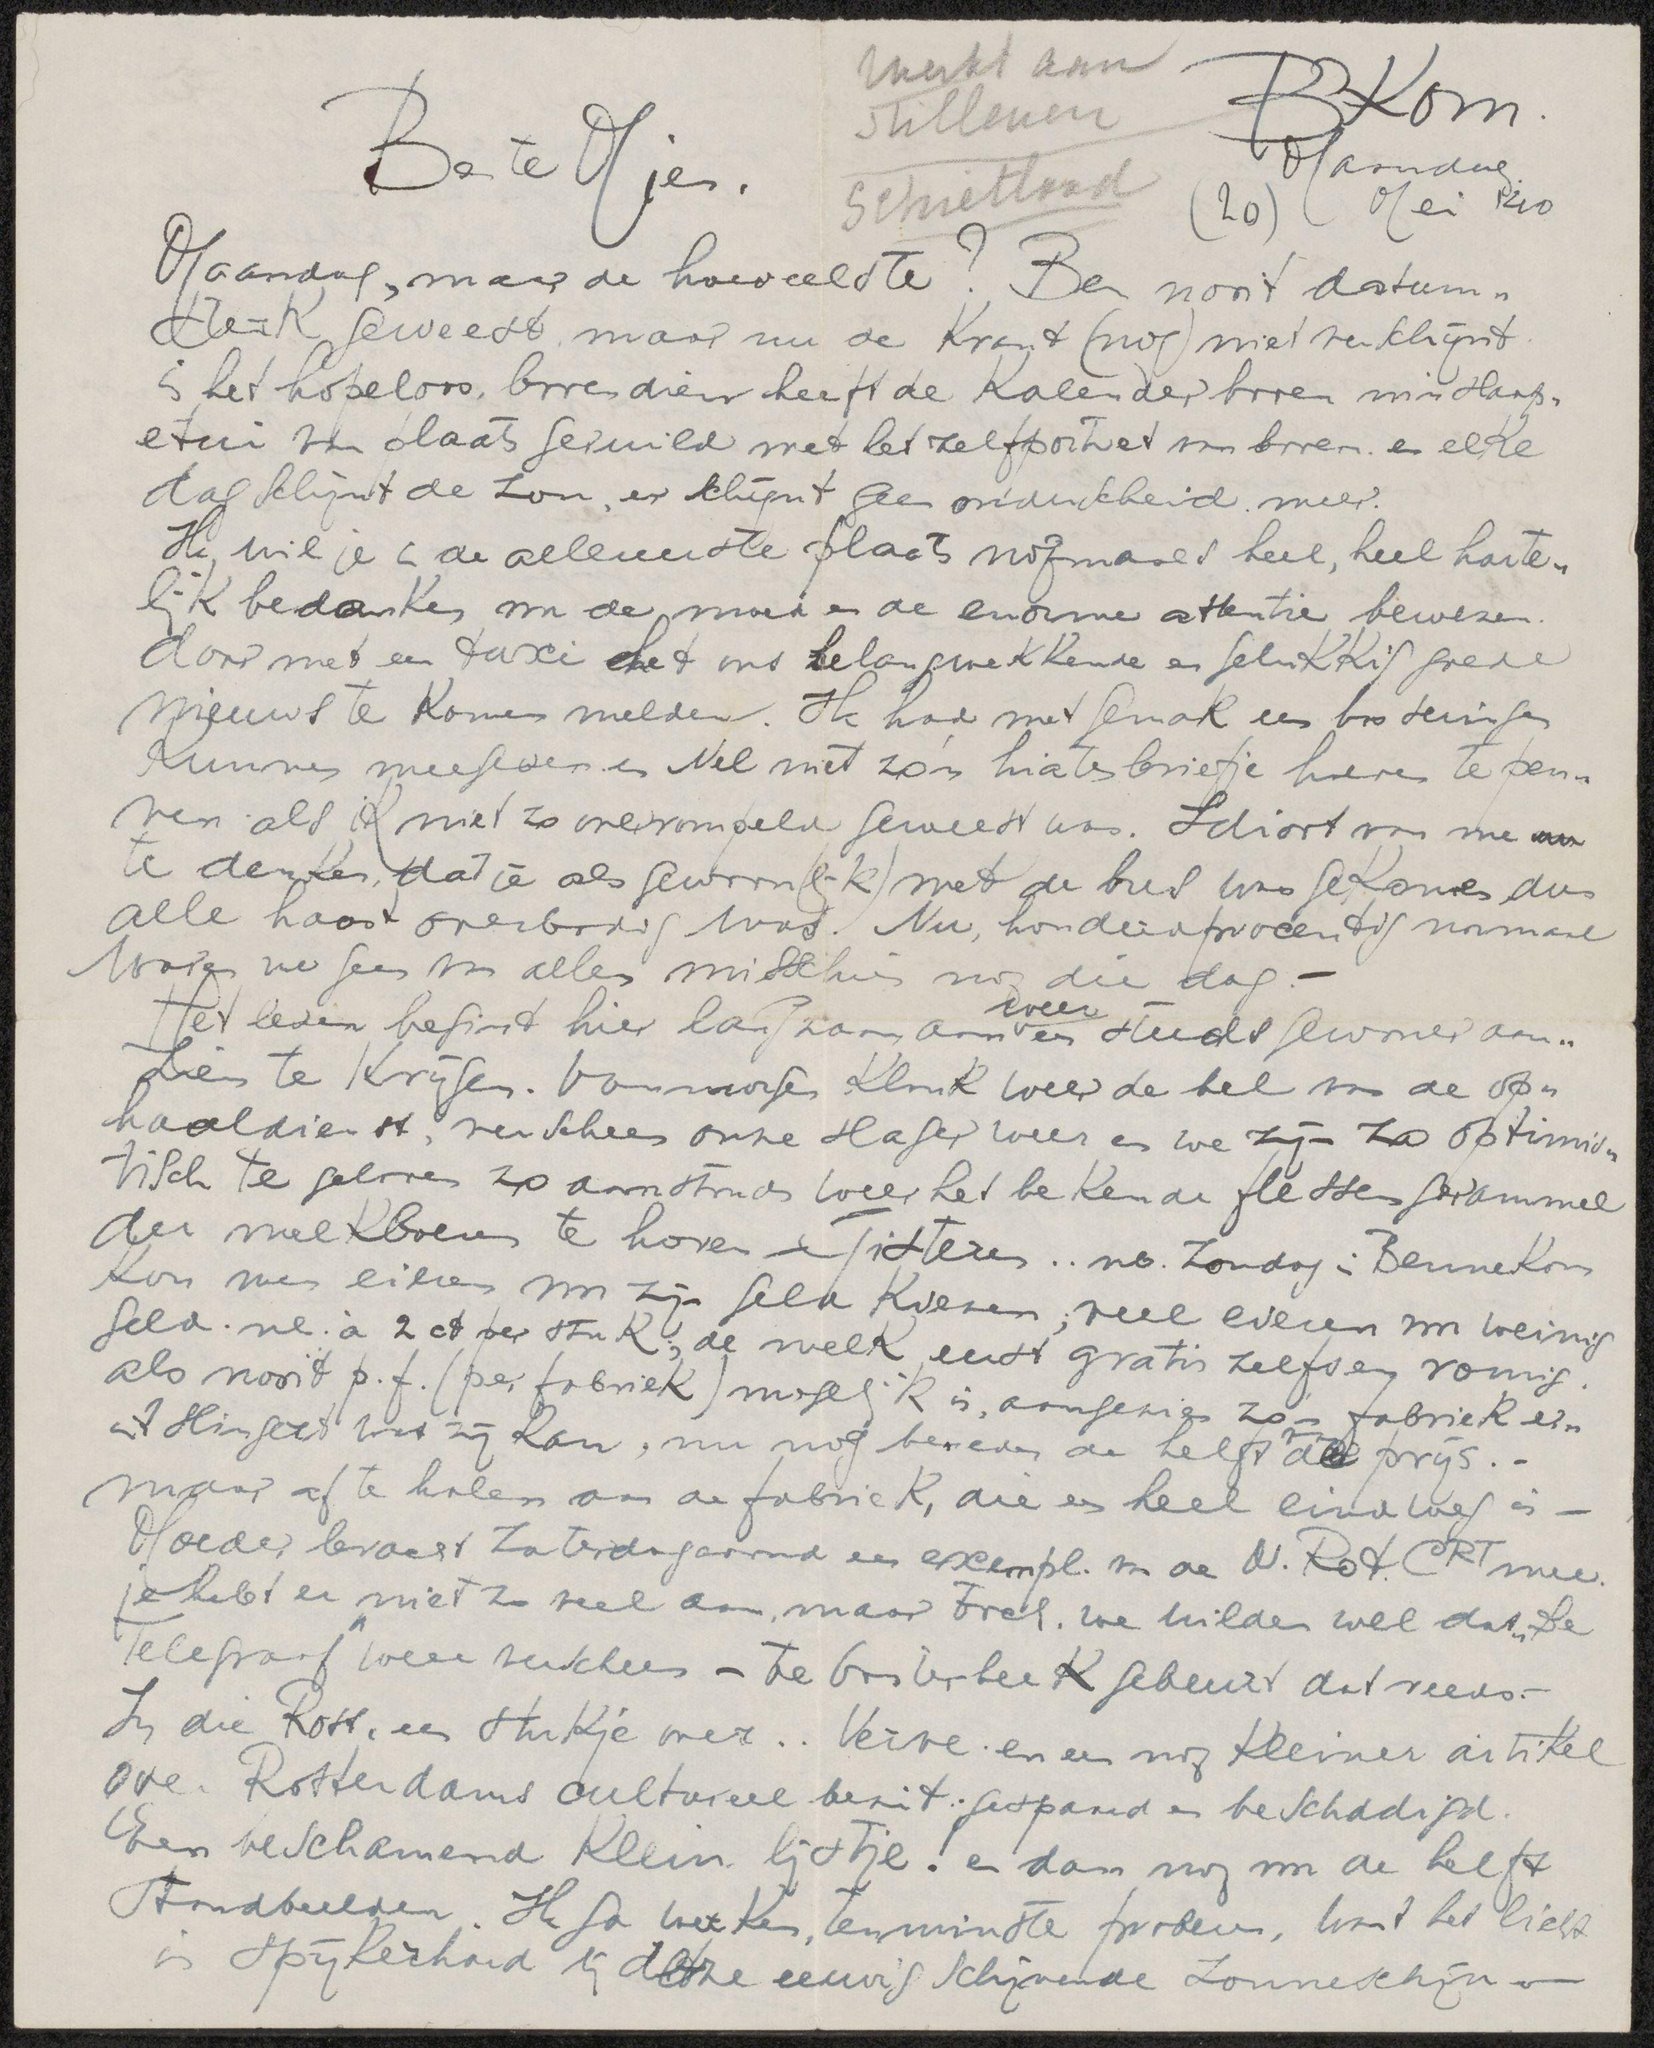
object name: letter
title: Brief aan Mien Cambier van Nooten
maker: dick ket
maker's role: draughtsman, print maker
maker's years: 1902-1940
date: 1940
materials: ink, paper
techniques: pen, writing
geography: bennekom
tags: painter, draughtsman, print maker, mien cambier van nooten, haarlem, dollmaker, textile artist, nelly johanna hagelen-schilt, workshop, studio of the artist (in general), historical persons (portraits and scenes from the life), rhenen